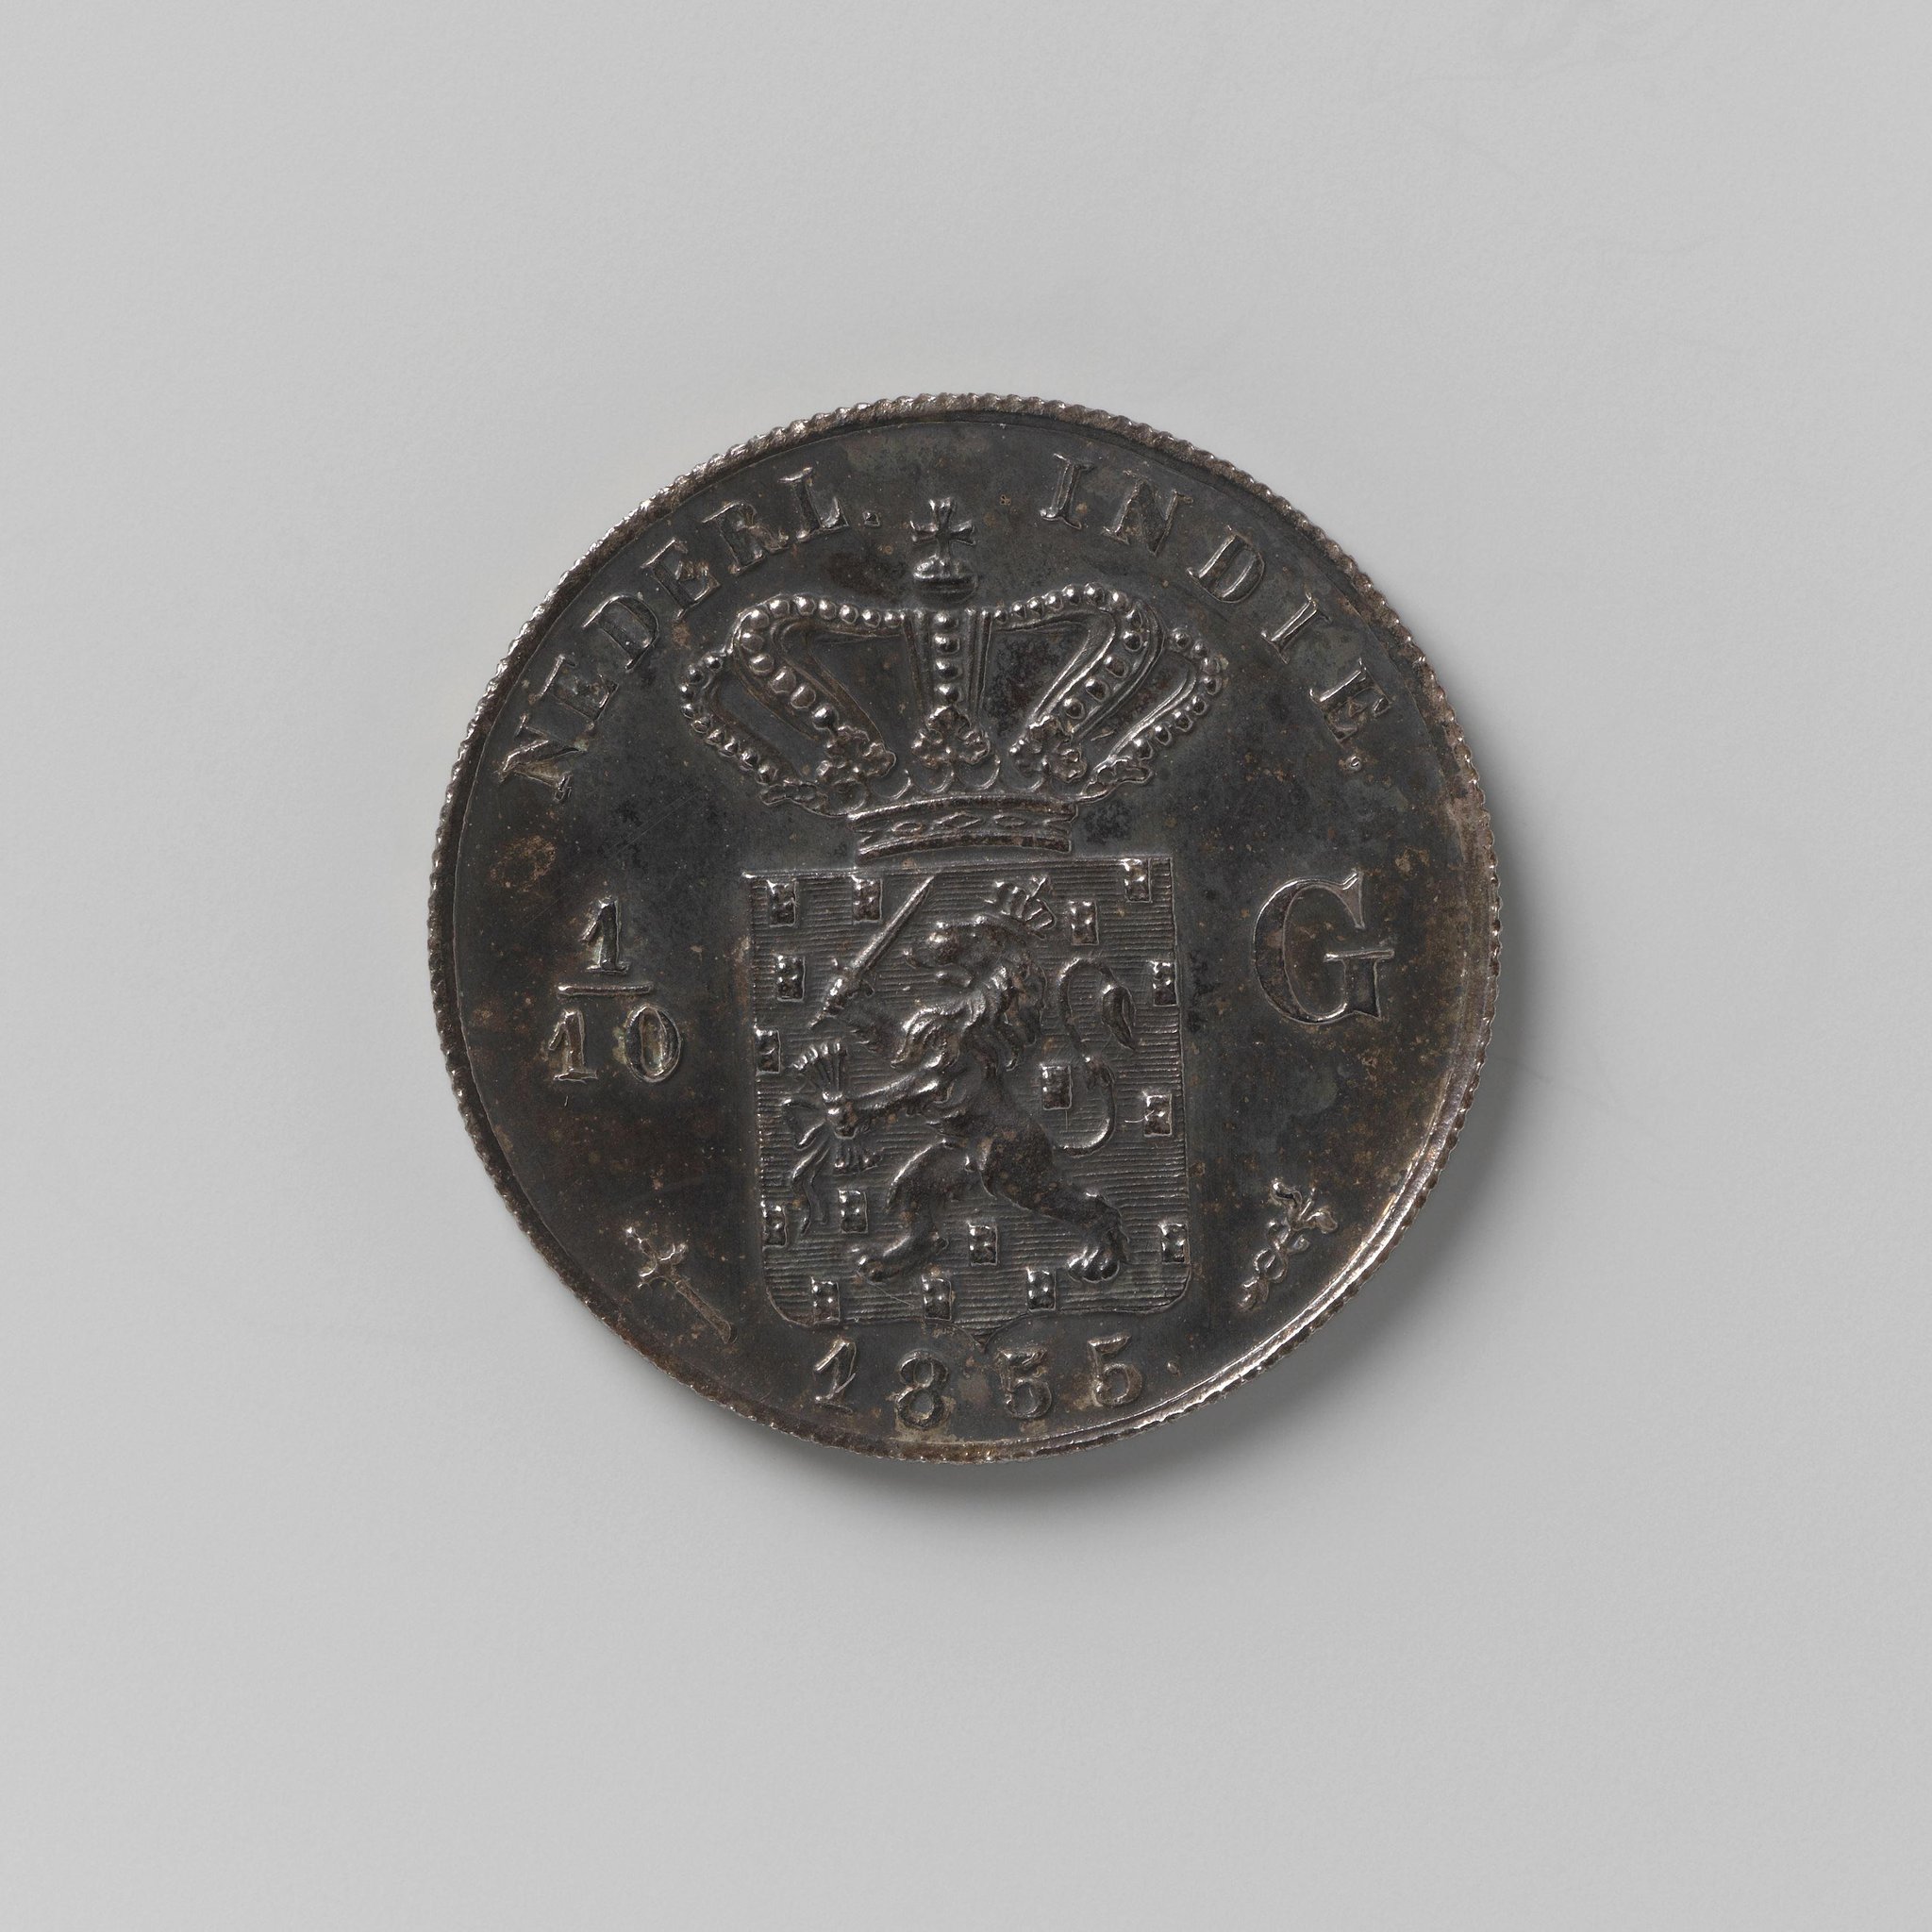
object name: coin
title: Nederlands Indië, 1/10 gulden, 1855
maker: willem iii (koning der nederlanden)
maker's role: koning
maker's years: 1817-1890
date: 1855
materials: silver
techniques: striking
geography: utrecht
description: Zilveren munt. Voorzijde: tussen waarde-aanduiding 1/10 G gekroond rijkswapenschild. Boven kroon landsaanduiding en onder wapenschild jaartal. Keerzijde: tweeregelig Maleis opschrift in Arabische tekens, waaromheen omschrift in het Javaans. Kartelrand.